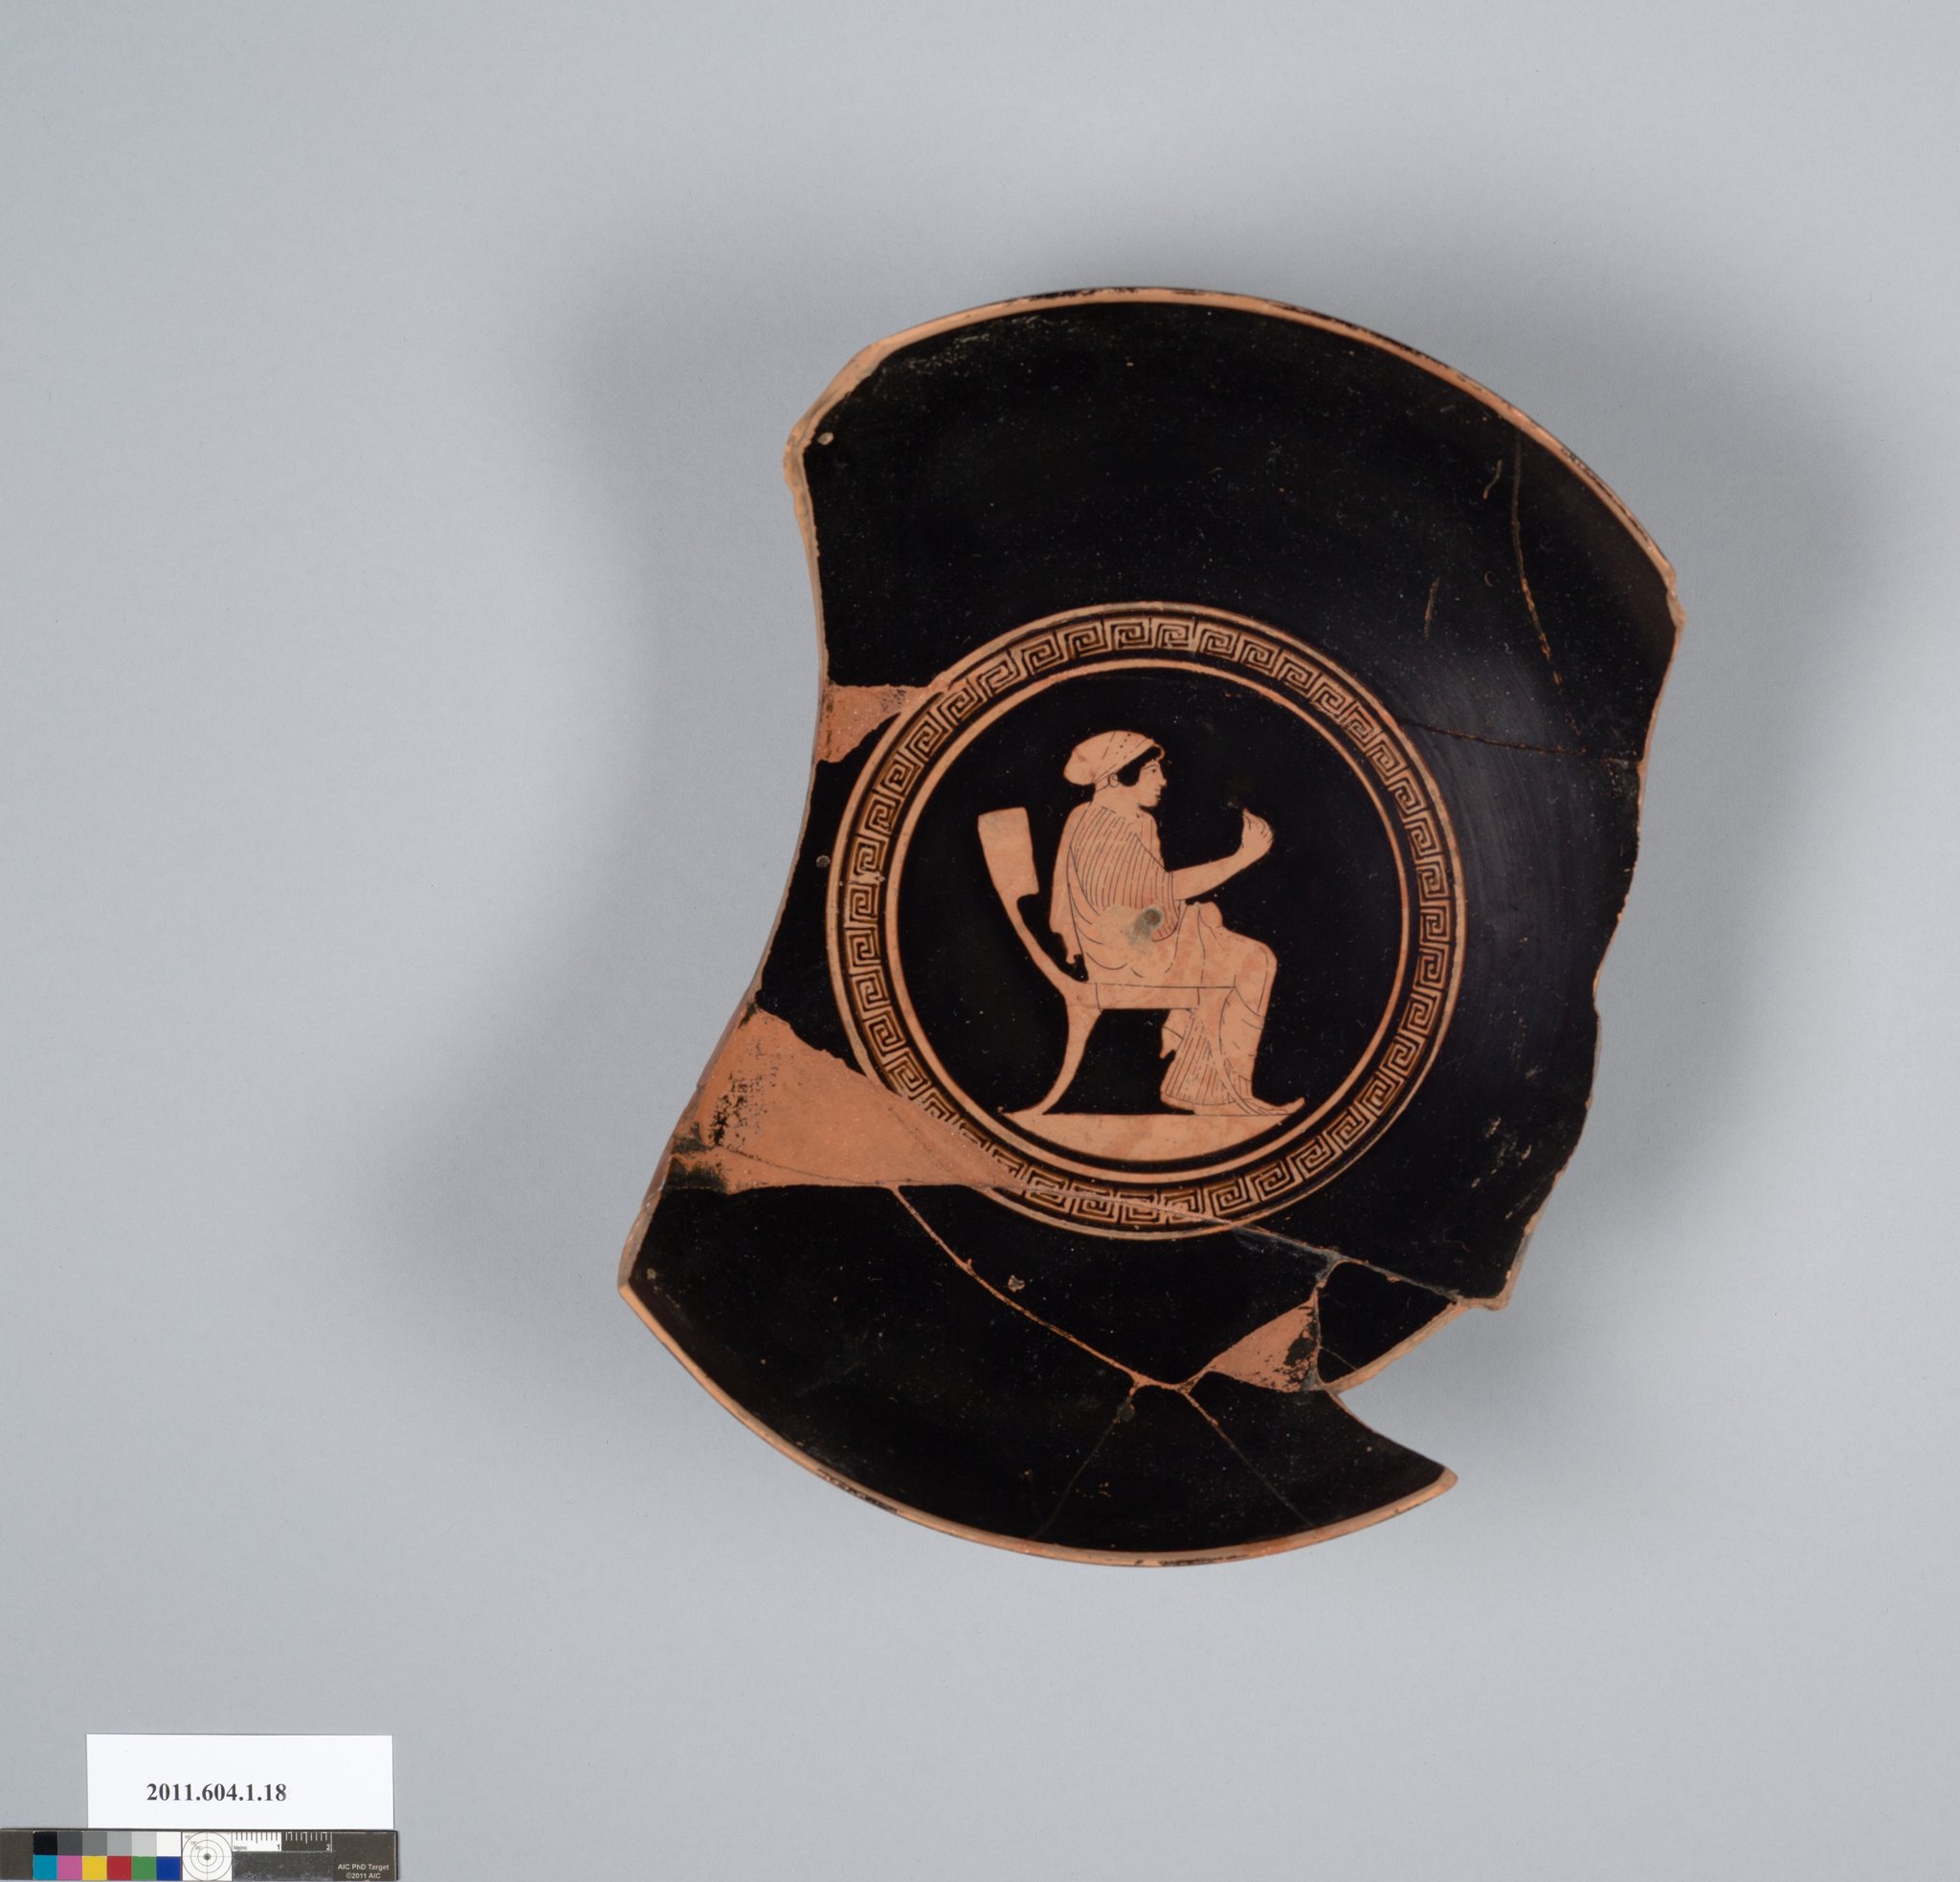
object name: kylix fragment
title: Terracotta fragments of a kylix (drinking cup)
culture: greek, attic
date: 470 BCE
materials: terracotta